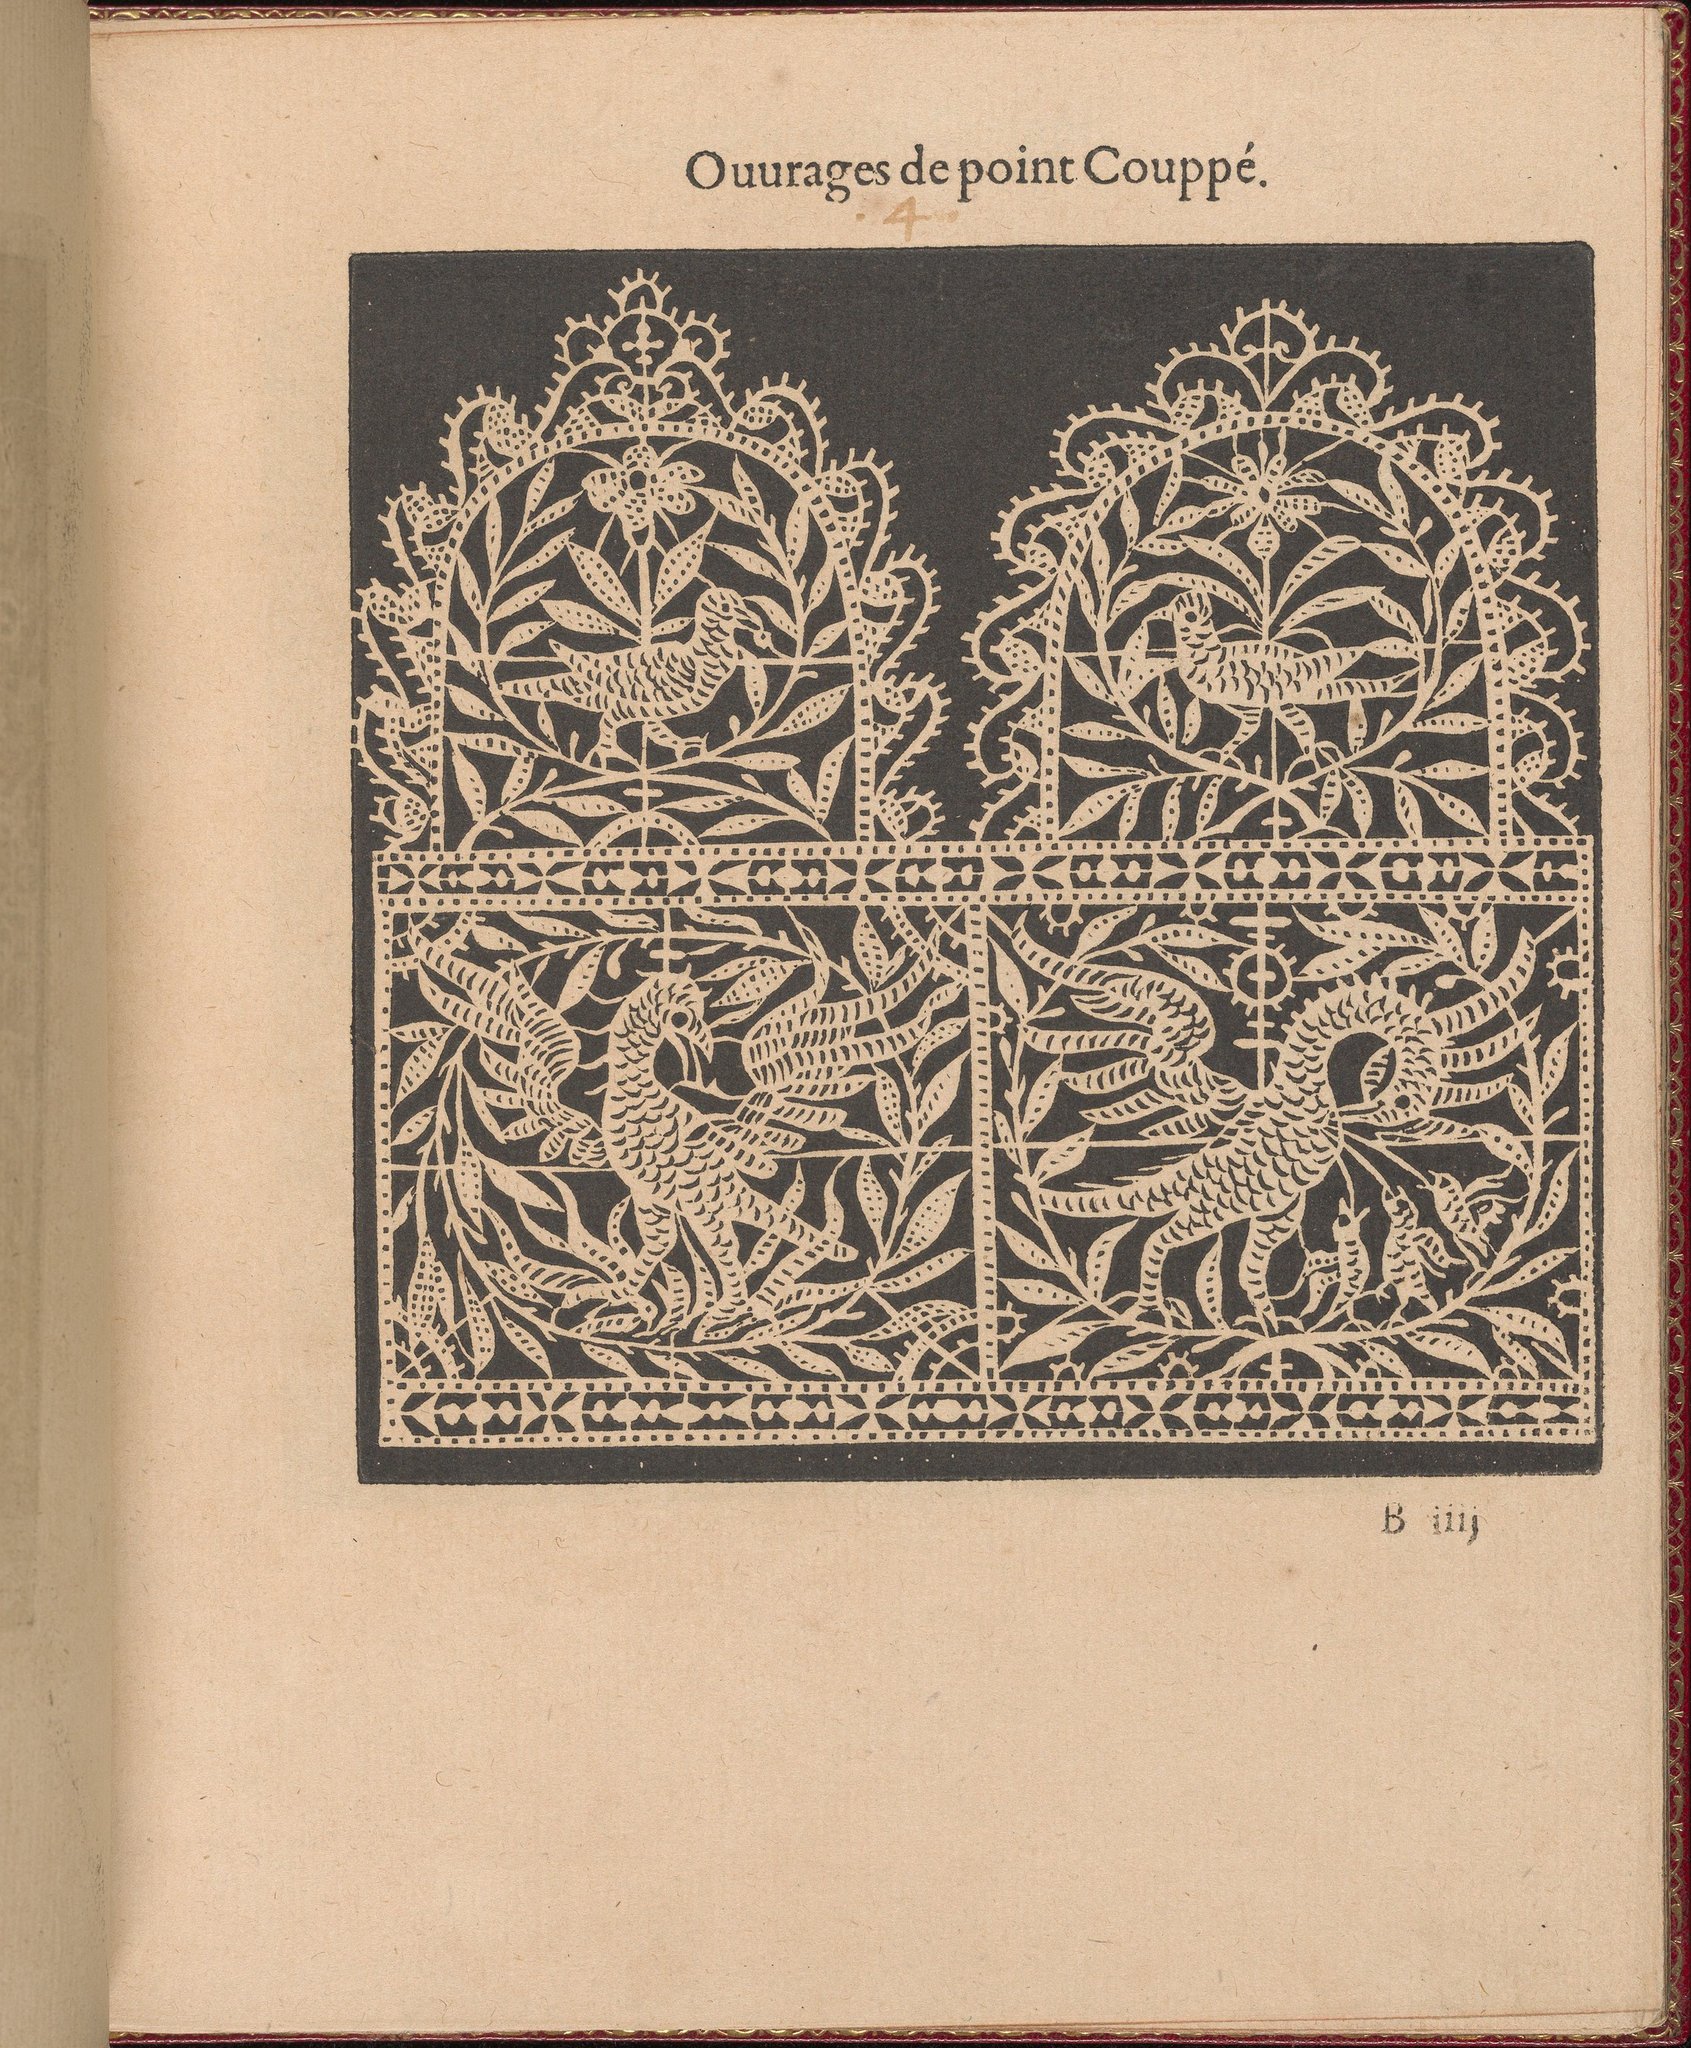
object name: book print ornament architecture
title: Les Singuliers et Nouveaux Portraicts... page 8 (recto)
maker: federico de vinciolo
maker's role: designer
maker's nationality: italian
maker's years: 1582-1599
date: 1588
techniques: woodcut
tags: birds